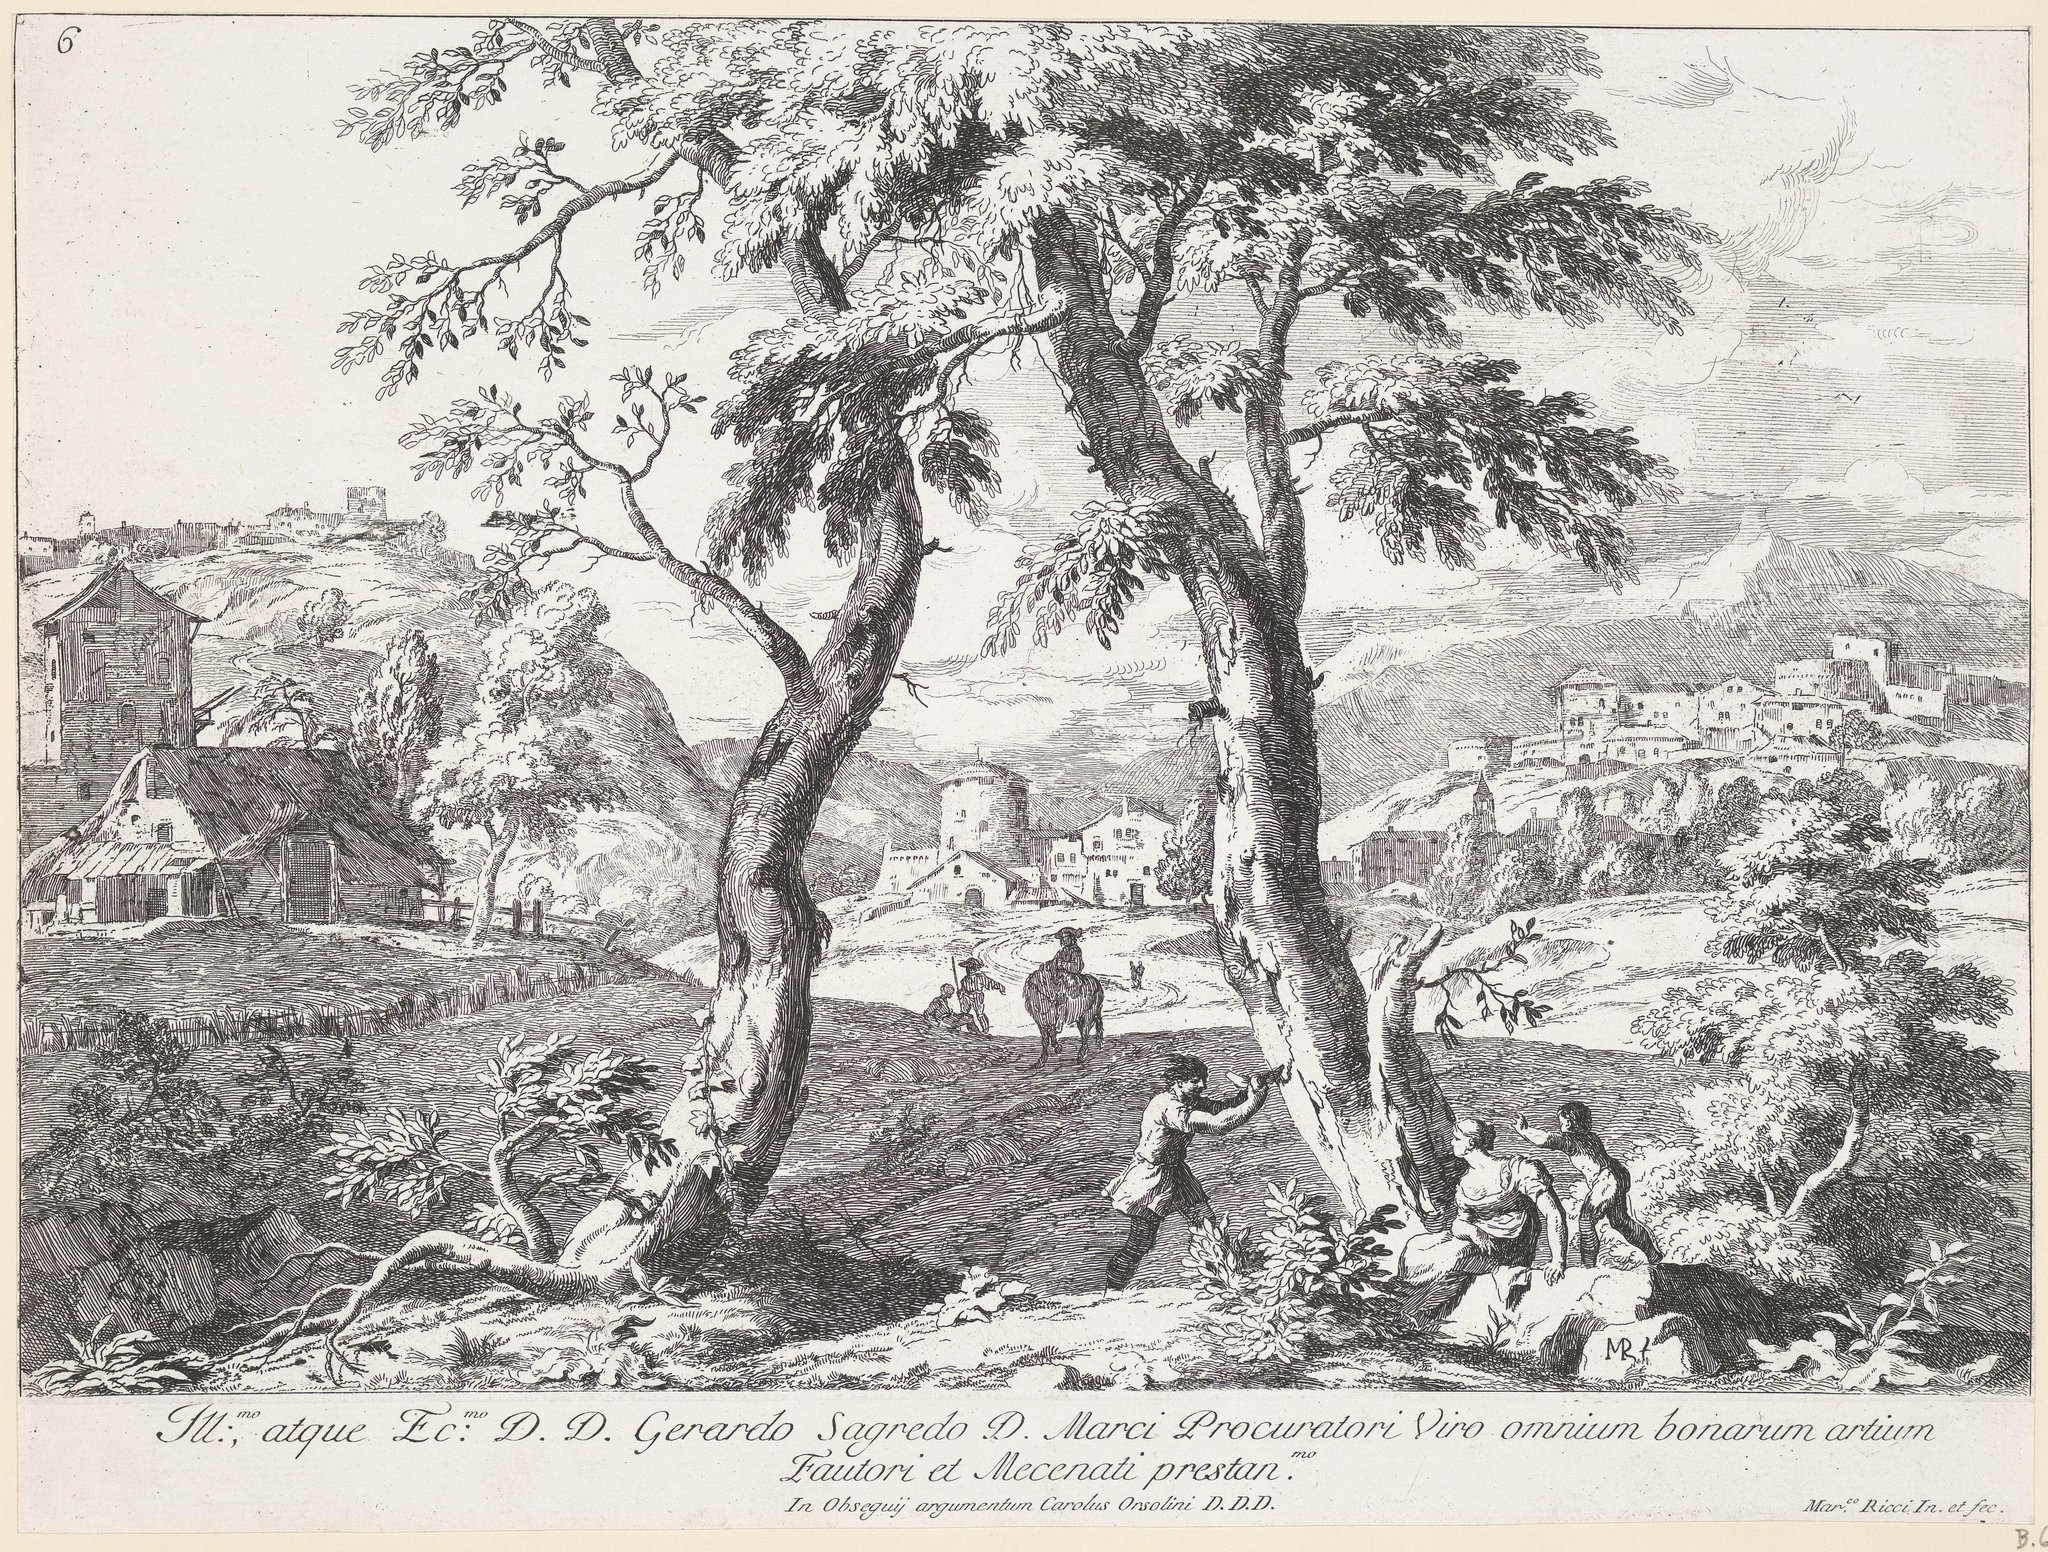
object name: print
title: Heuvellandschap met huizen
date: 1730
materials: paper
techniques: etching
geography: italy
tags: landscapes, village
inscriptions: collector's mark: Lugt 2228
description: Deze prent maakt deel uit van een reeks van twintig prenten door Marco Ricci. De prenten zijn na de dood van Ricci in 1730 gebundeld door Carlo Orsolini en voorzien van een titelprent. Een getekende voorstudie wordt bewaard in de National Gallery of Scotland in Edinburgh (inv. nr. D. 626).